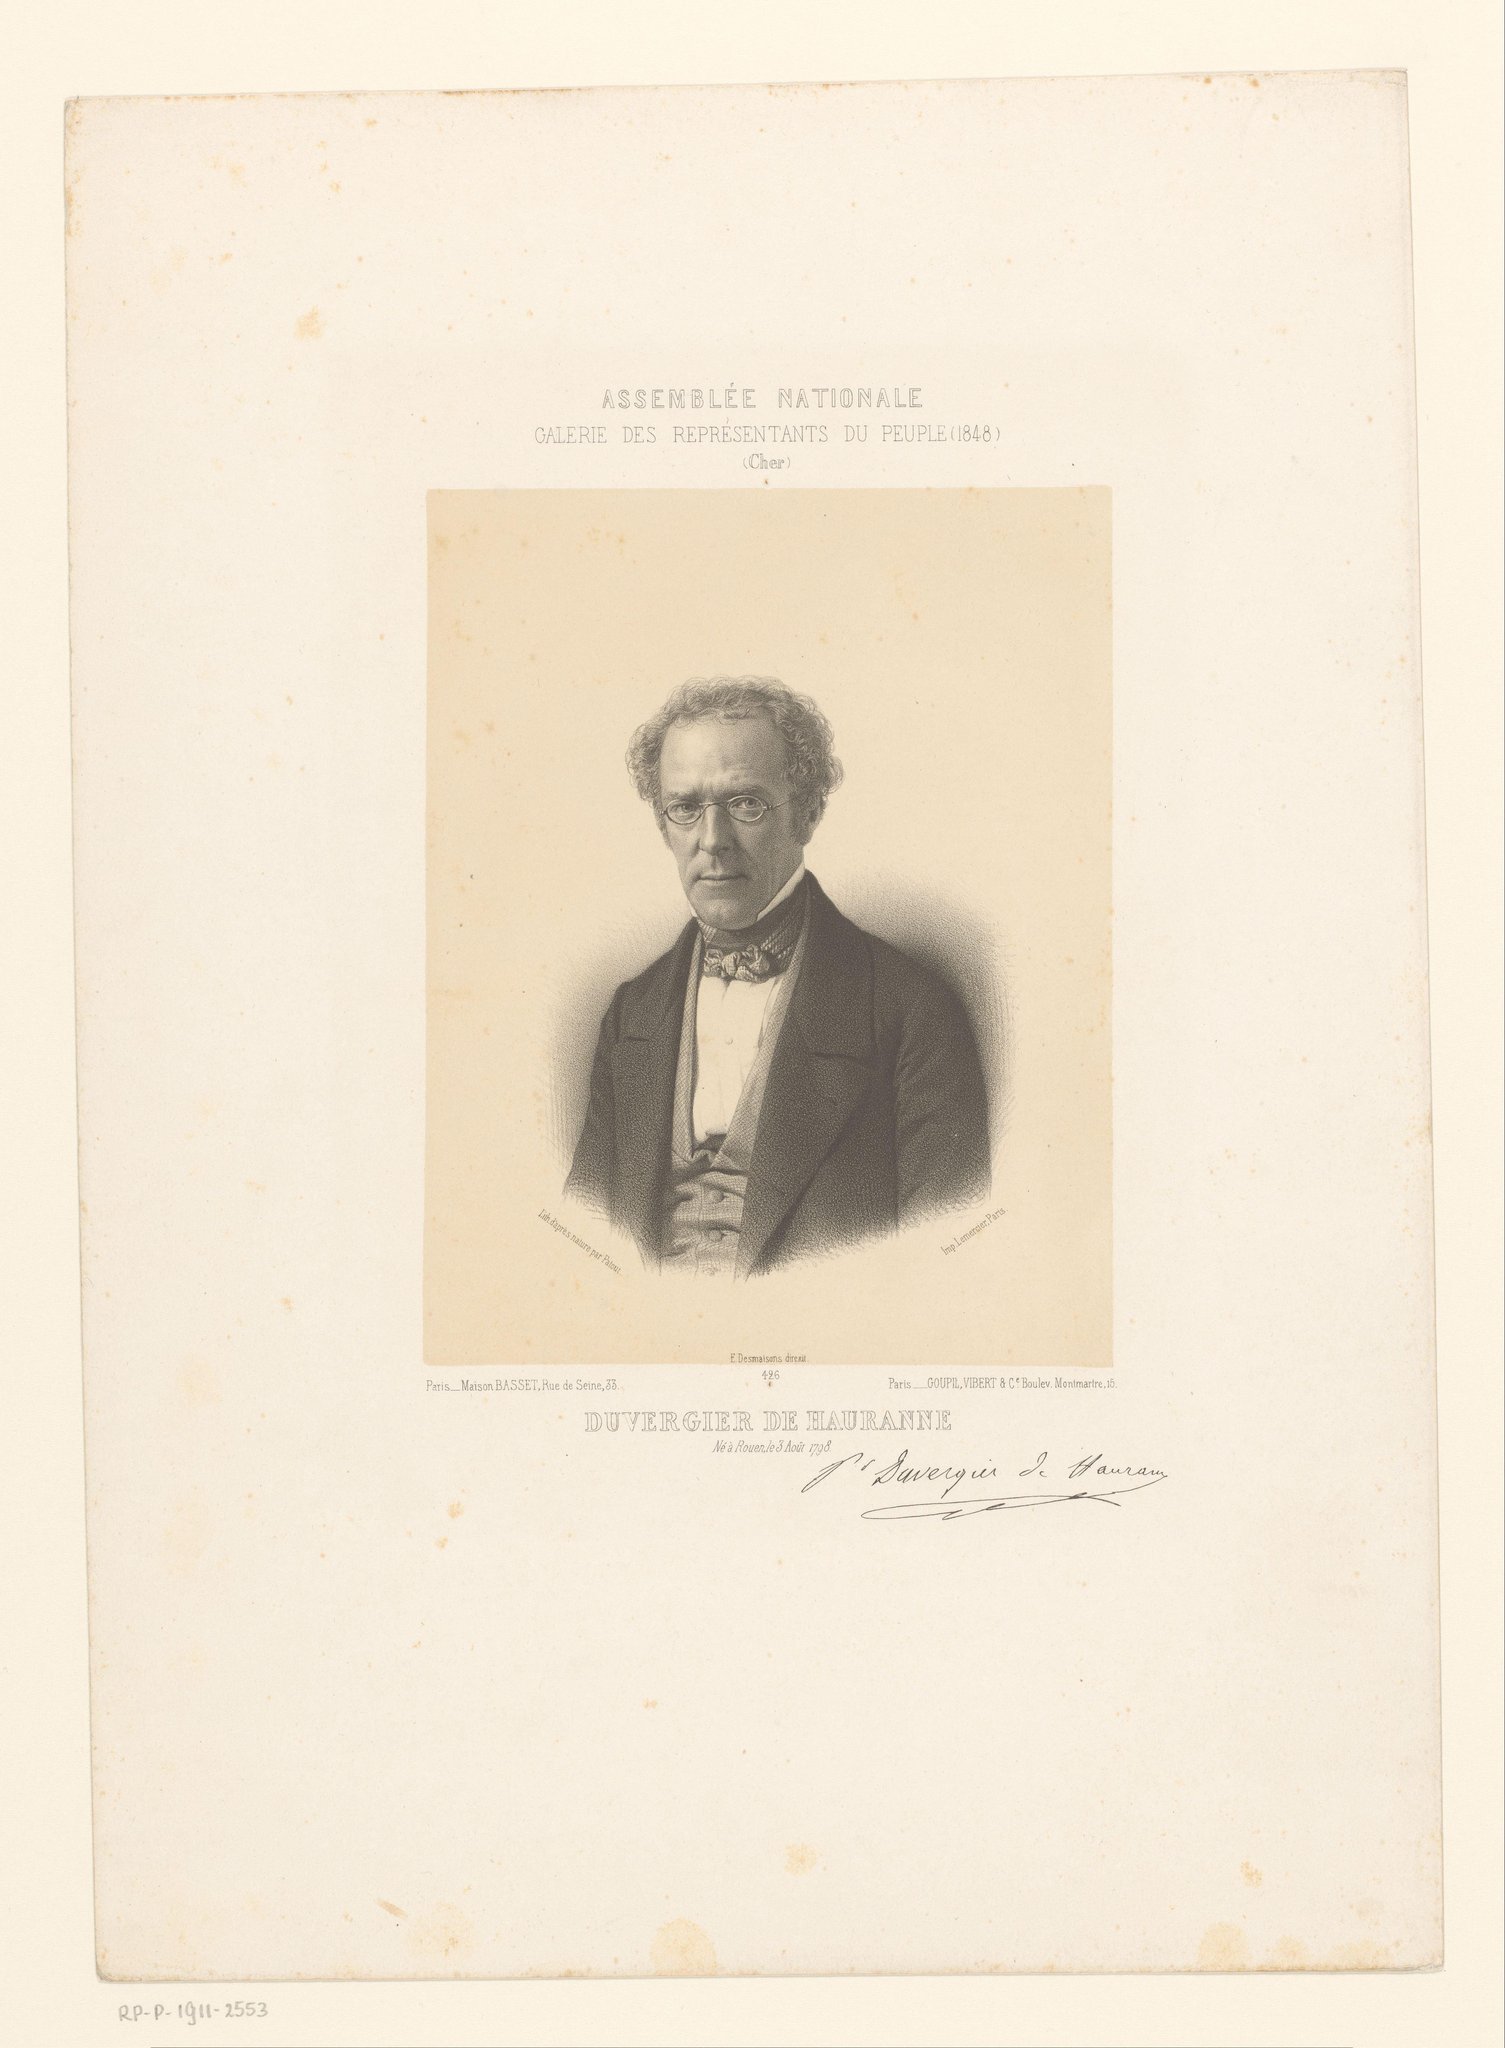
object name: print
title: Assemblée Nationale. Galerie des représentants du peuple (1848)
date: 1848-1849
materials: paper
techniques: tone lithography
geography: paris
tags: journalist, reporter, historical persons, politician, e.g. party leader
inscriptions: collector's mark: Lugt 2228